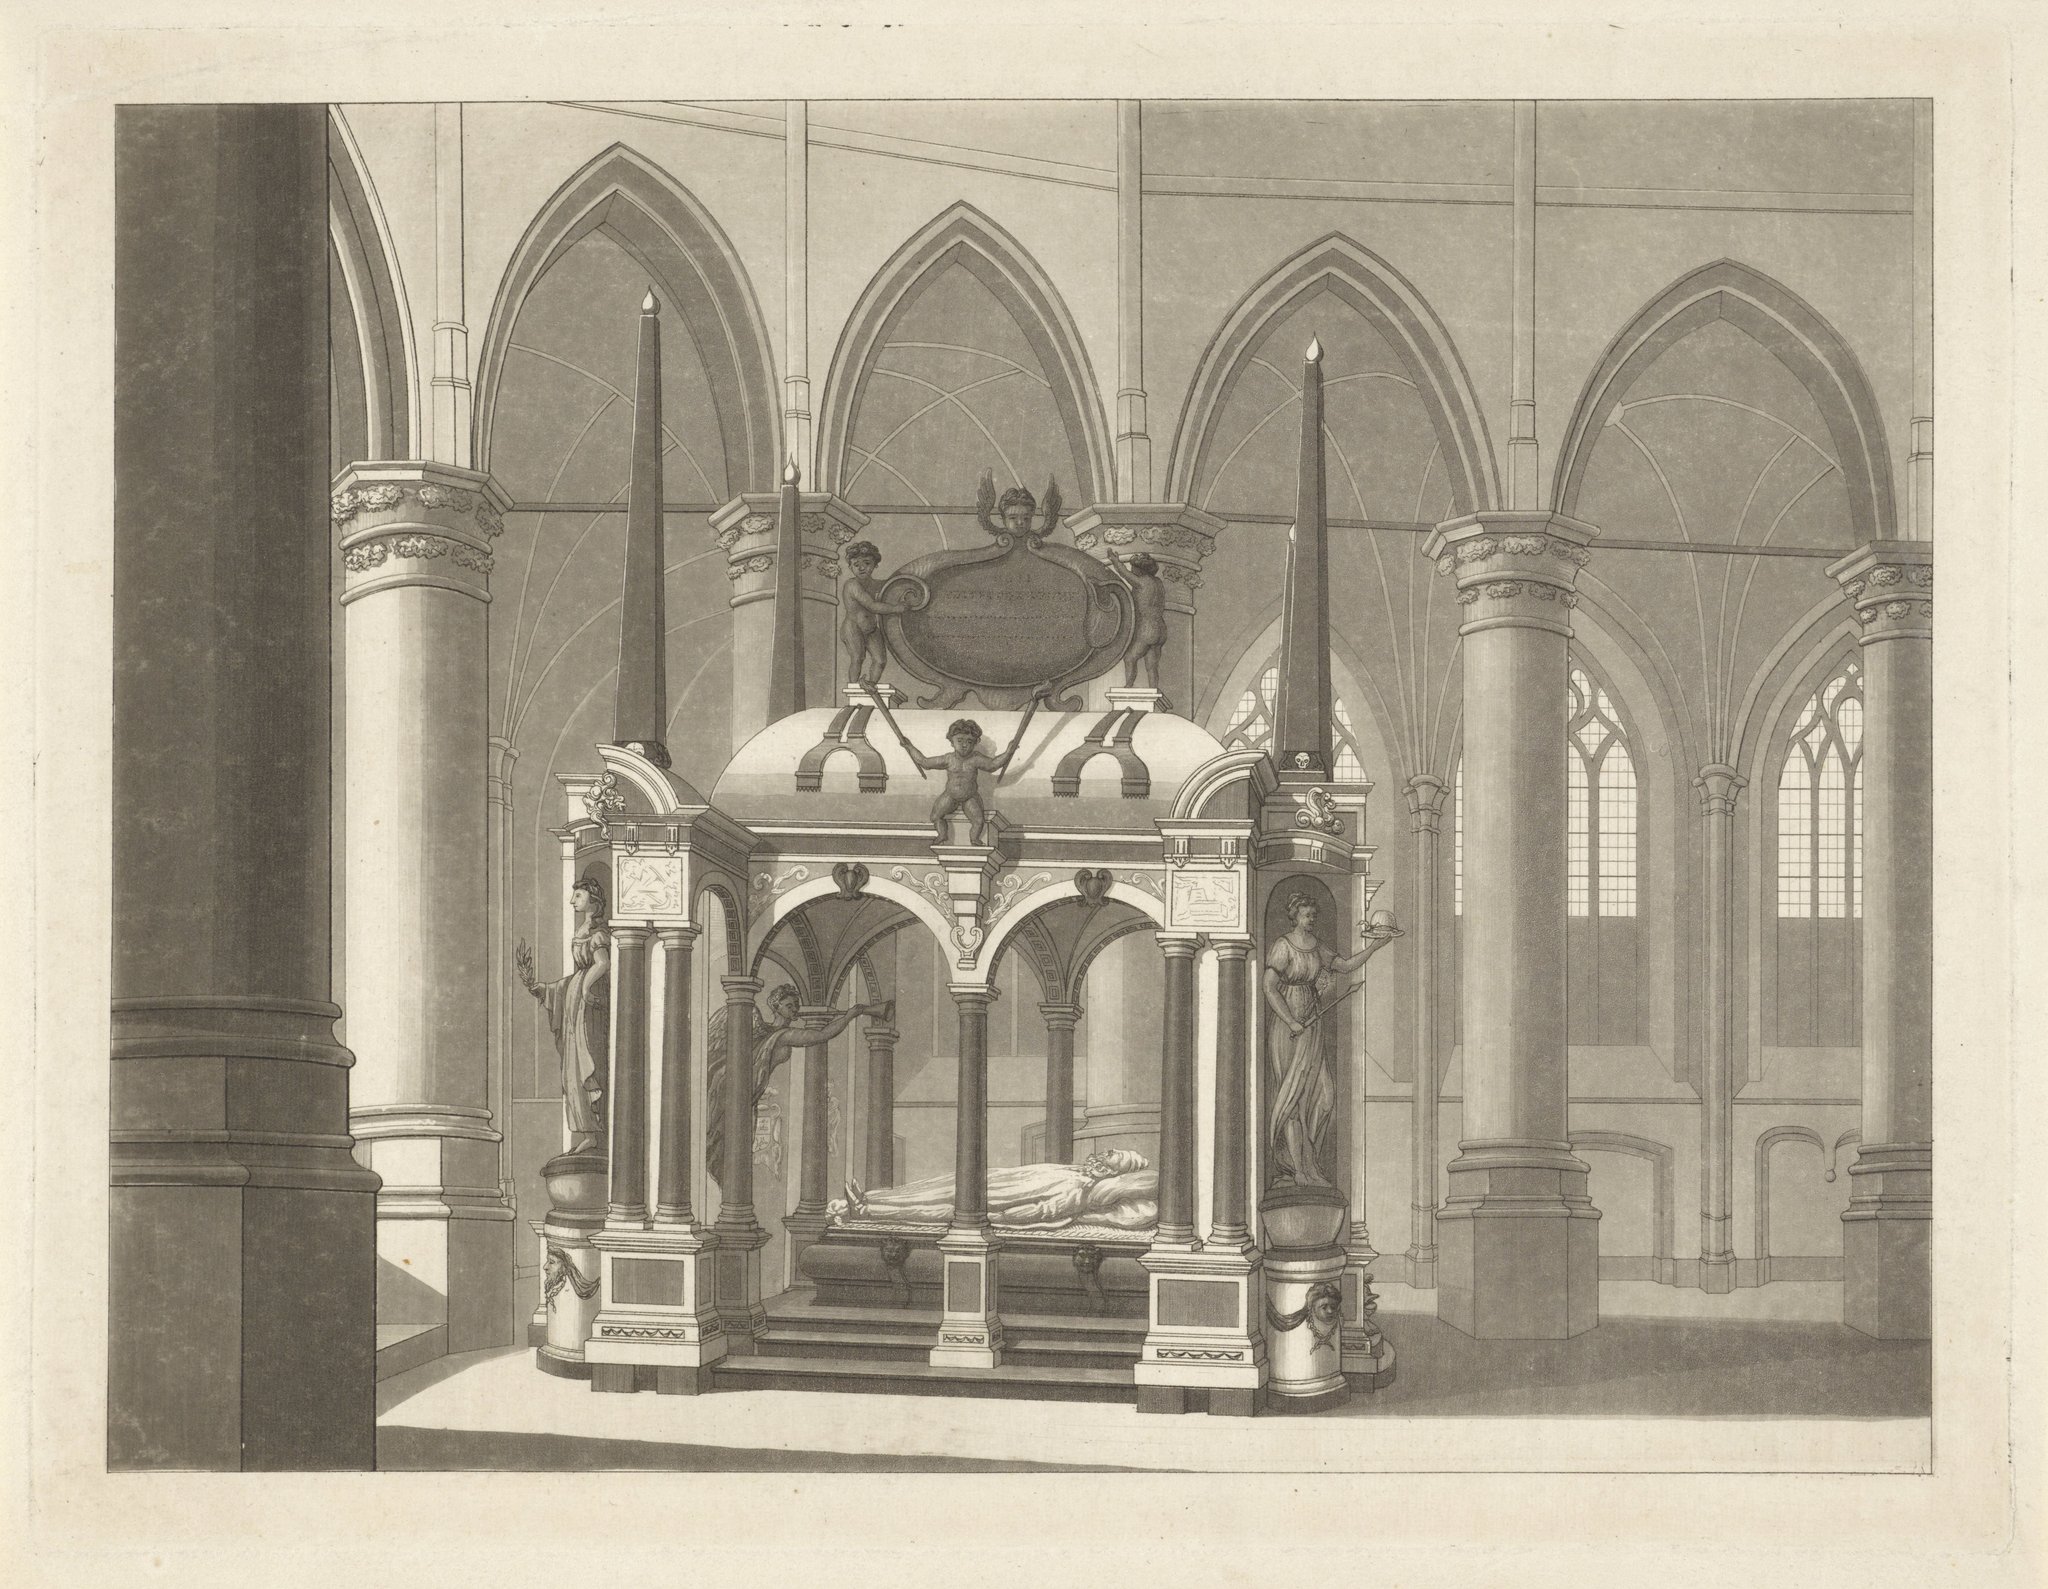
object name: print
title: Praalgraf van prins Willem I van Oranje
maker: johannes cornelis zürcher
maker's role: print maker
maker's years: 1794-1882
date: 1804-1882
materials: paper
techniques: aquatint, etching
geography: amsterdam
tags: delft, william i (prince of orange), mausoleum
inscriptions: collector's mark: Lugt 2228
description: Zijaanzicht van het praalgraf van Willem I, prins van Oranje, in de Nieuwe Kerk te Delft.